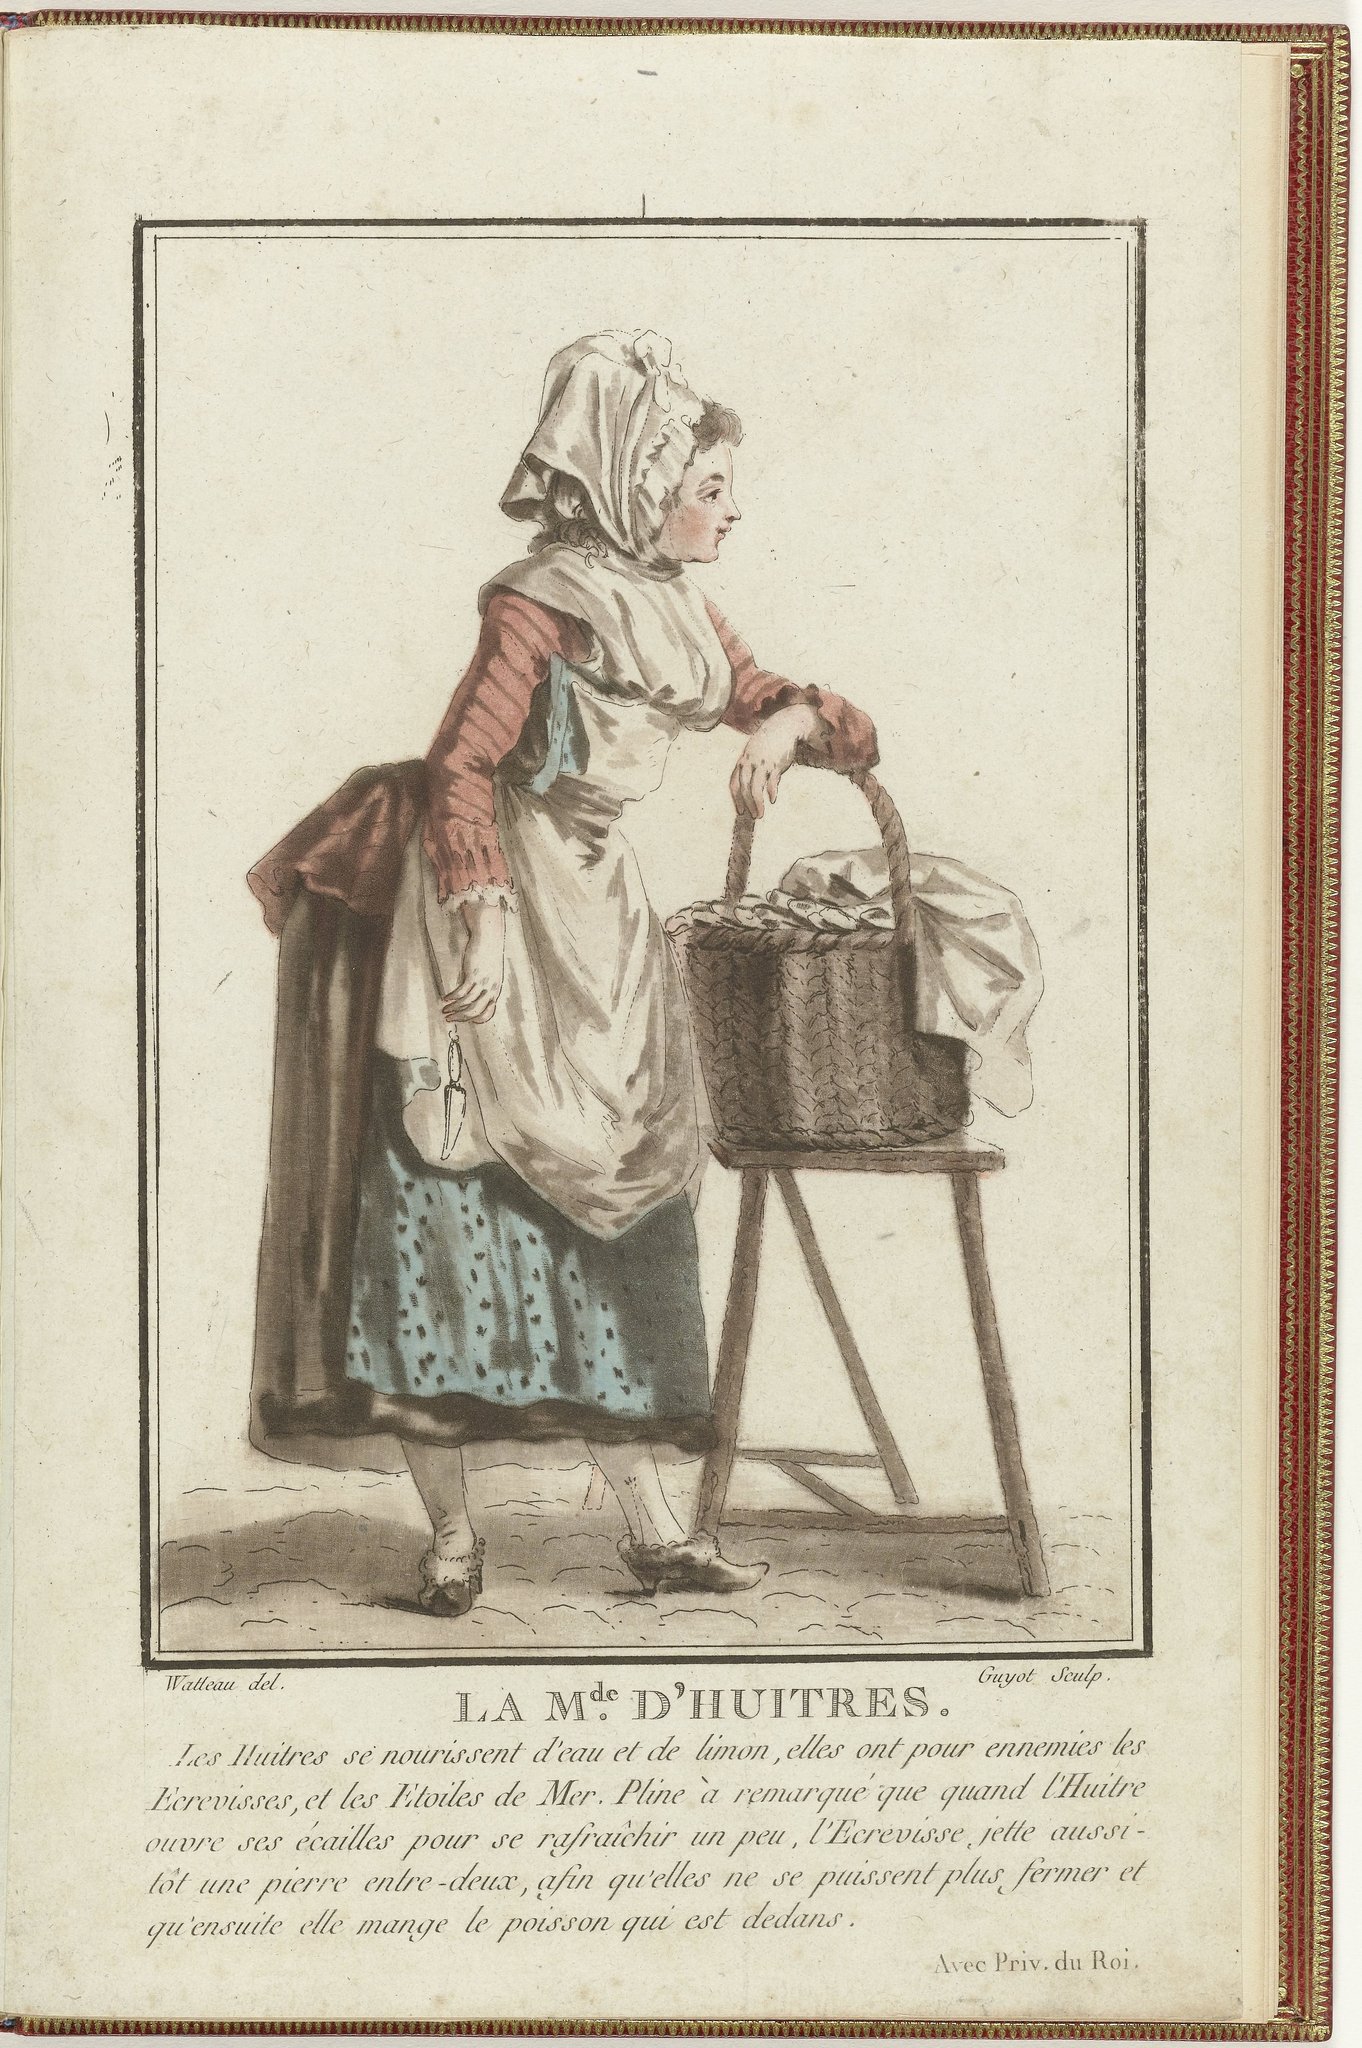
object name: costume print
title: Cris et costumes de Paris...dessiné par Watteau et Gravé en Couleur par Guyot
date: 1786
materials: paper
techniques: aquatint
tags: clothes, costume (+ women's clothes), 'cris de paris', cries of london, etc.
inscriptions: privilege: ‘Avec Priv. du Roi.’, caption: ‘Les Huitres se nourissent d'eau et de limon, elles ont pour ennemies les Ecrevisses, et les Etoiles de Mer. Pline a remarqué que quand l' Huitre ouvre ses écailles pour se rafraichir un peu, l'Ecrevisse jette aussitot une pierre entre-deux, afin qu'elles ne se puissent plus fermes et qu'ensuite elle mange le poisson qui est dedans.’, signature: ‘Guyot sculp.’, title: ‘LA MDE. D'HUITRES’, signature: ‘Watteau del.’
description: Elegant gekleed oesterverkoopstertje uit Parijs. Ze leunt op haar mand met oesters die op een tafeltje staat.